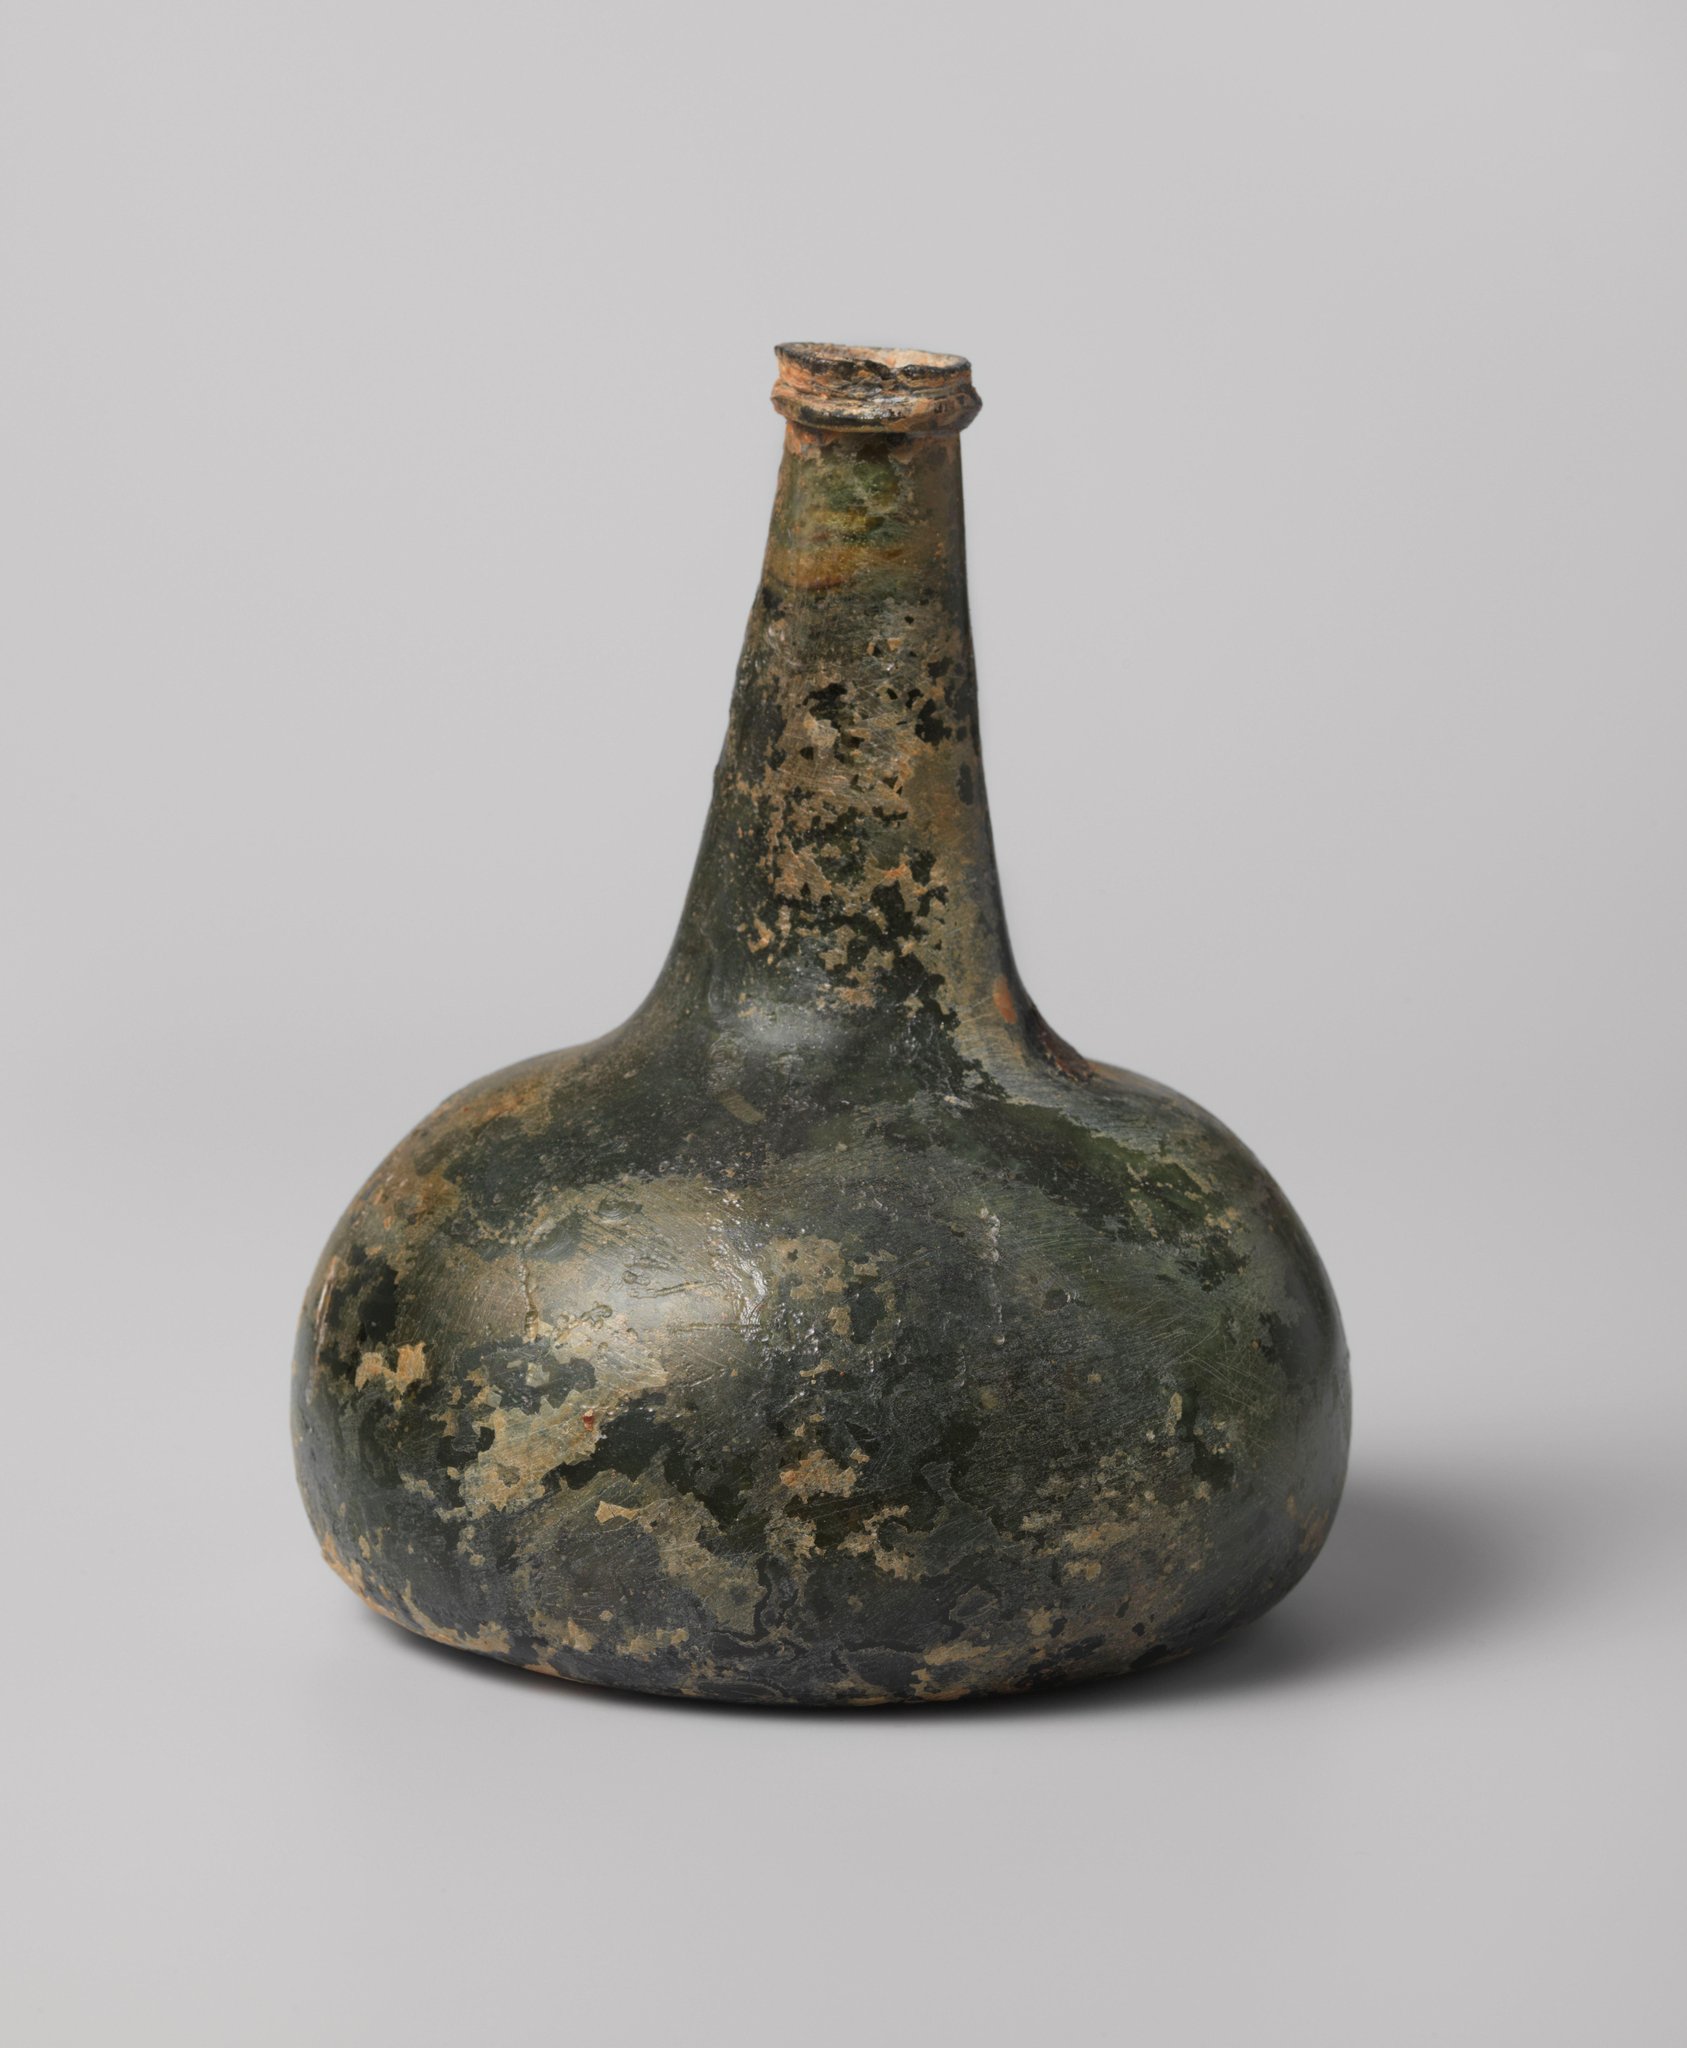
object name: wine bottle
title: Wijnfles uit het wrak van de Oost-Indiëvaarder Hollandia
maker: Anonymous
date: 1700-1743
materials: glass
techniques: green glass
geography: netherlands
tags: verenigde oostindische compagnie, hollandia (schip), annet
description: Wijnfles zonder kurk, een scherf ontbreekt. Wine bottle, continental production, onion-shaped, complete; (1) eroded (17h, belly 14.2d, base 10d), vs-string rim, tcs-kick-up.